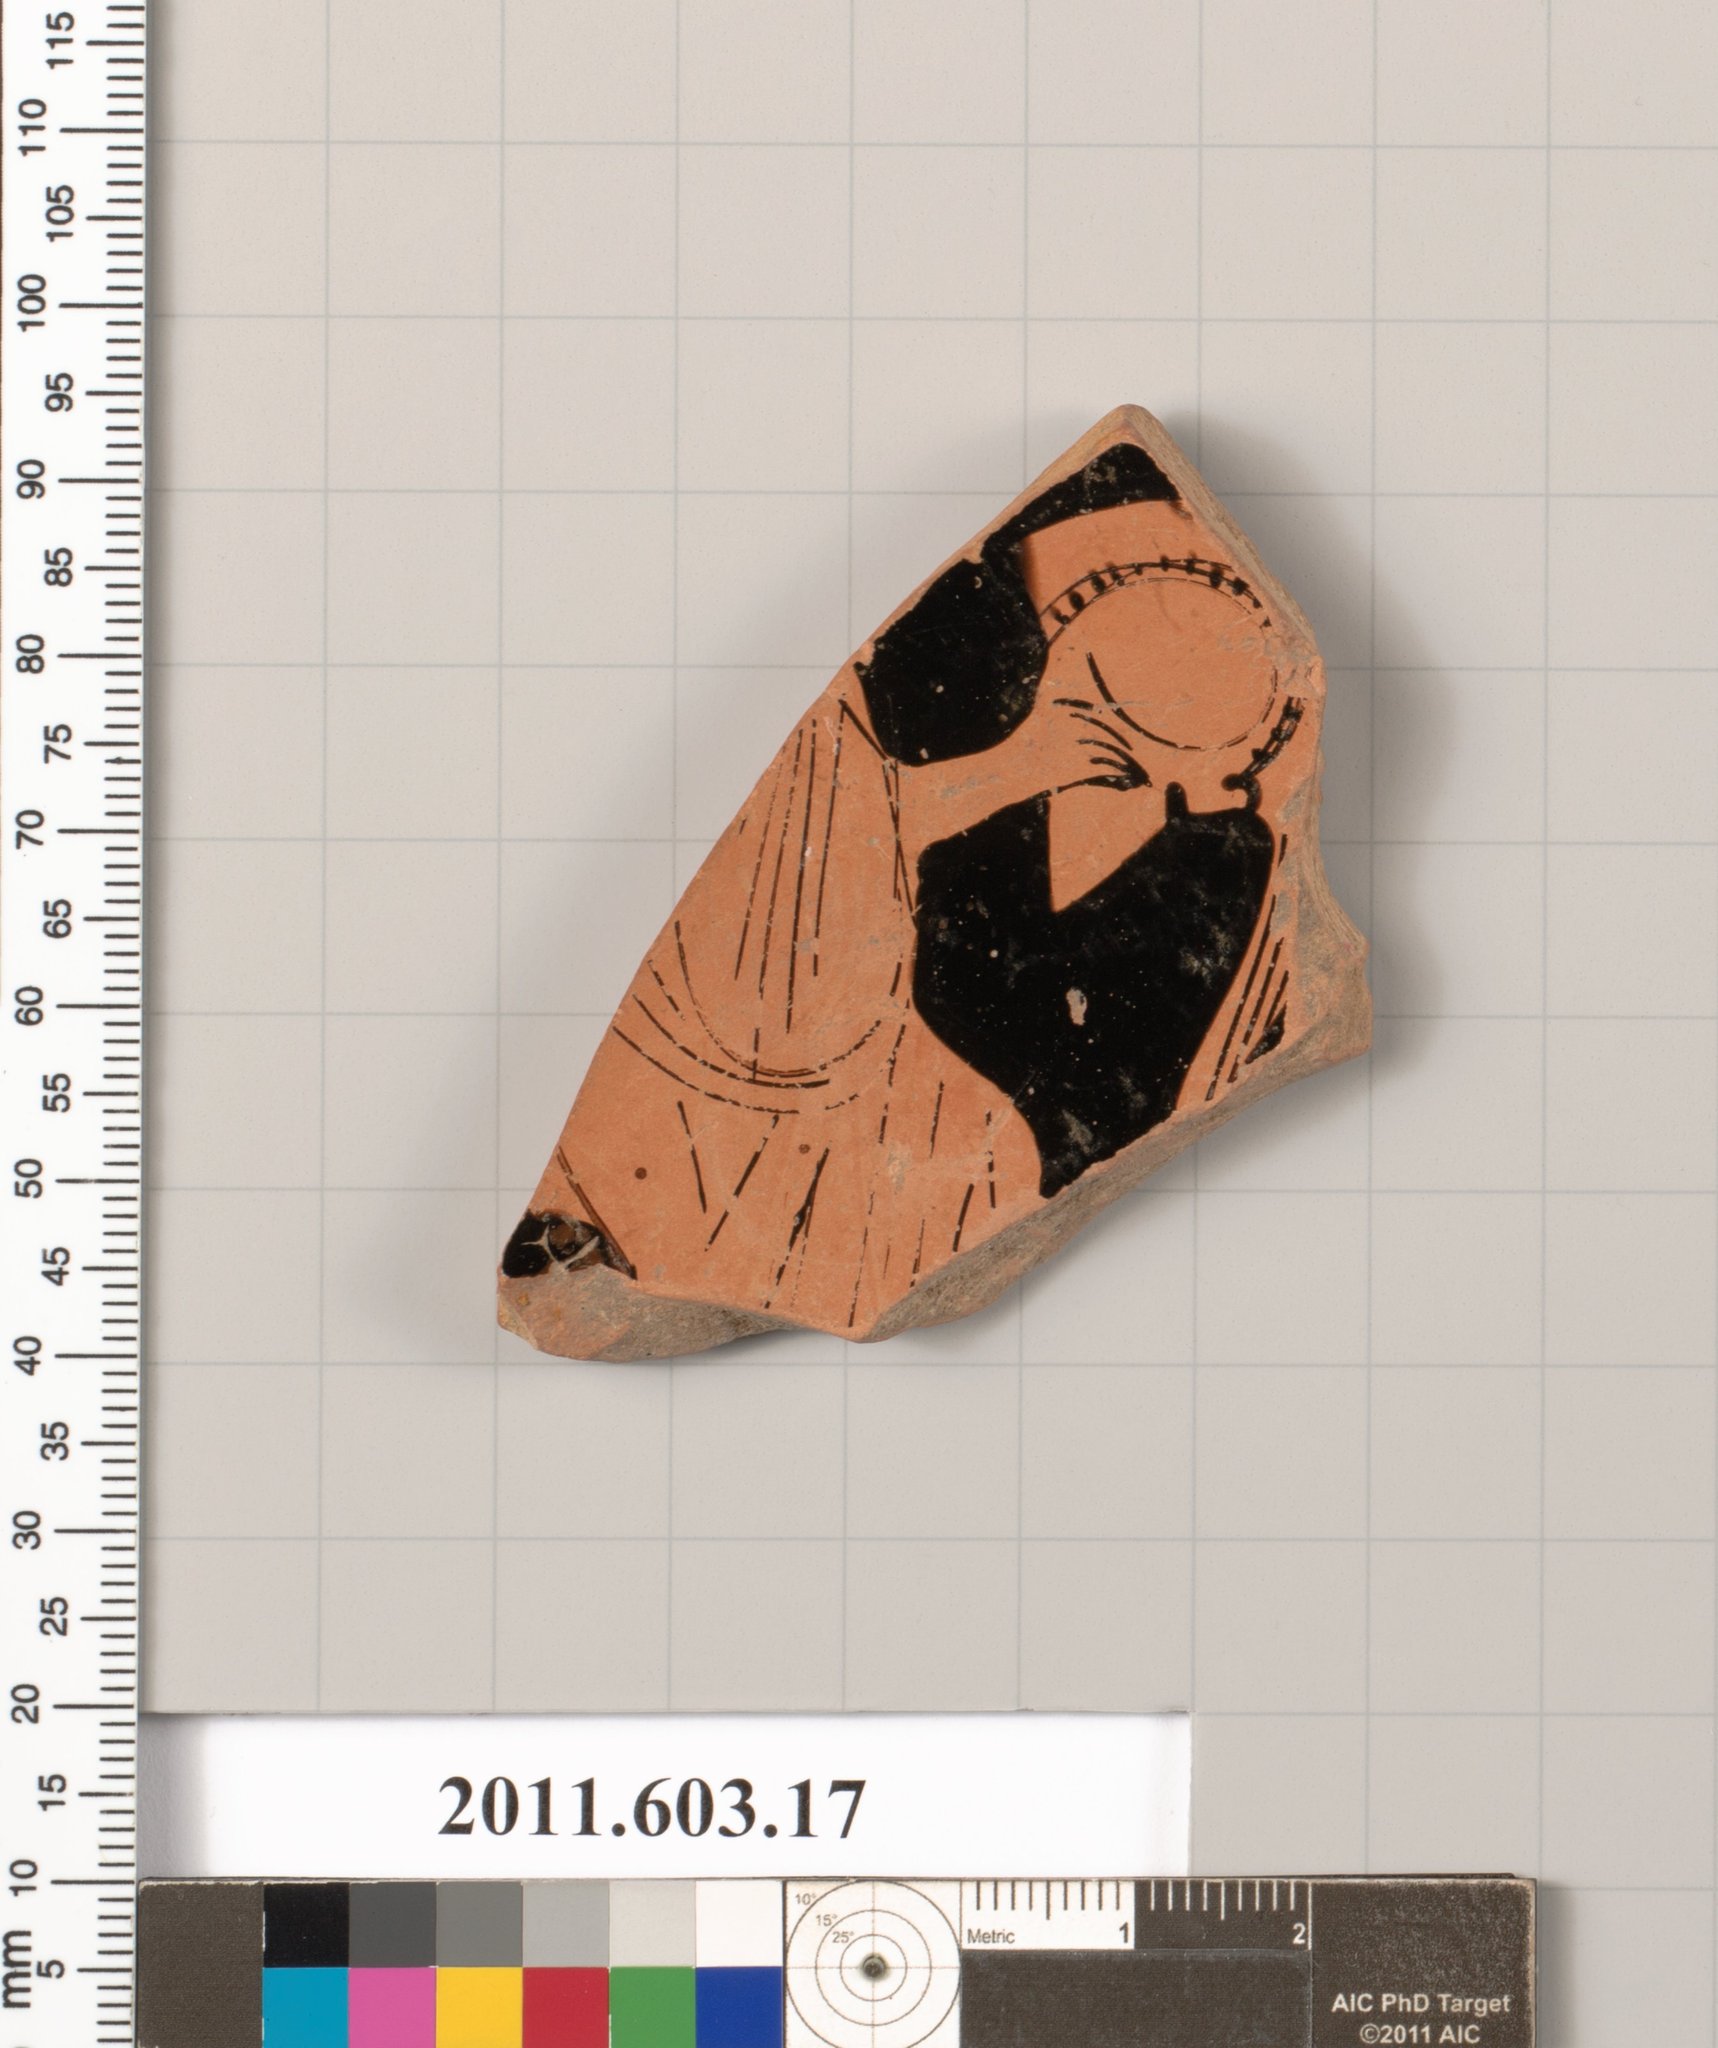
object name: kylix fragment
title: Fragment of a terracotta stemless kylix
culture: greek, attic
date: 467-435 BCE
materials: terracotta